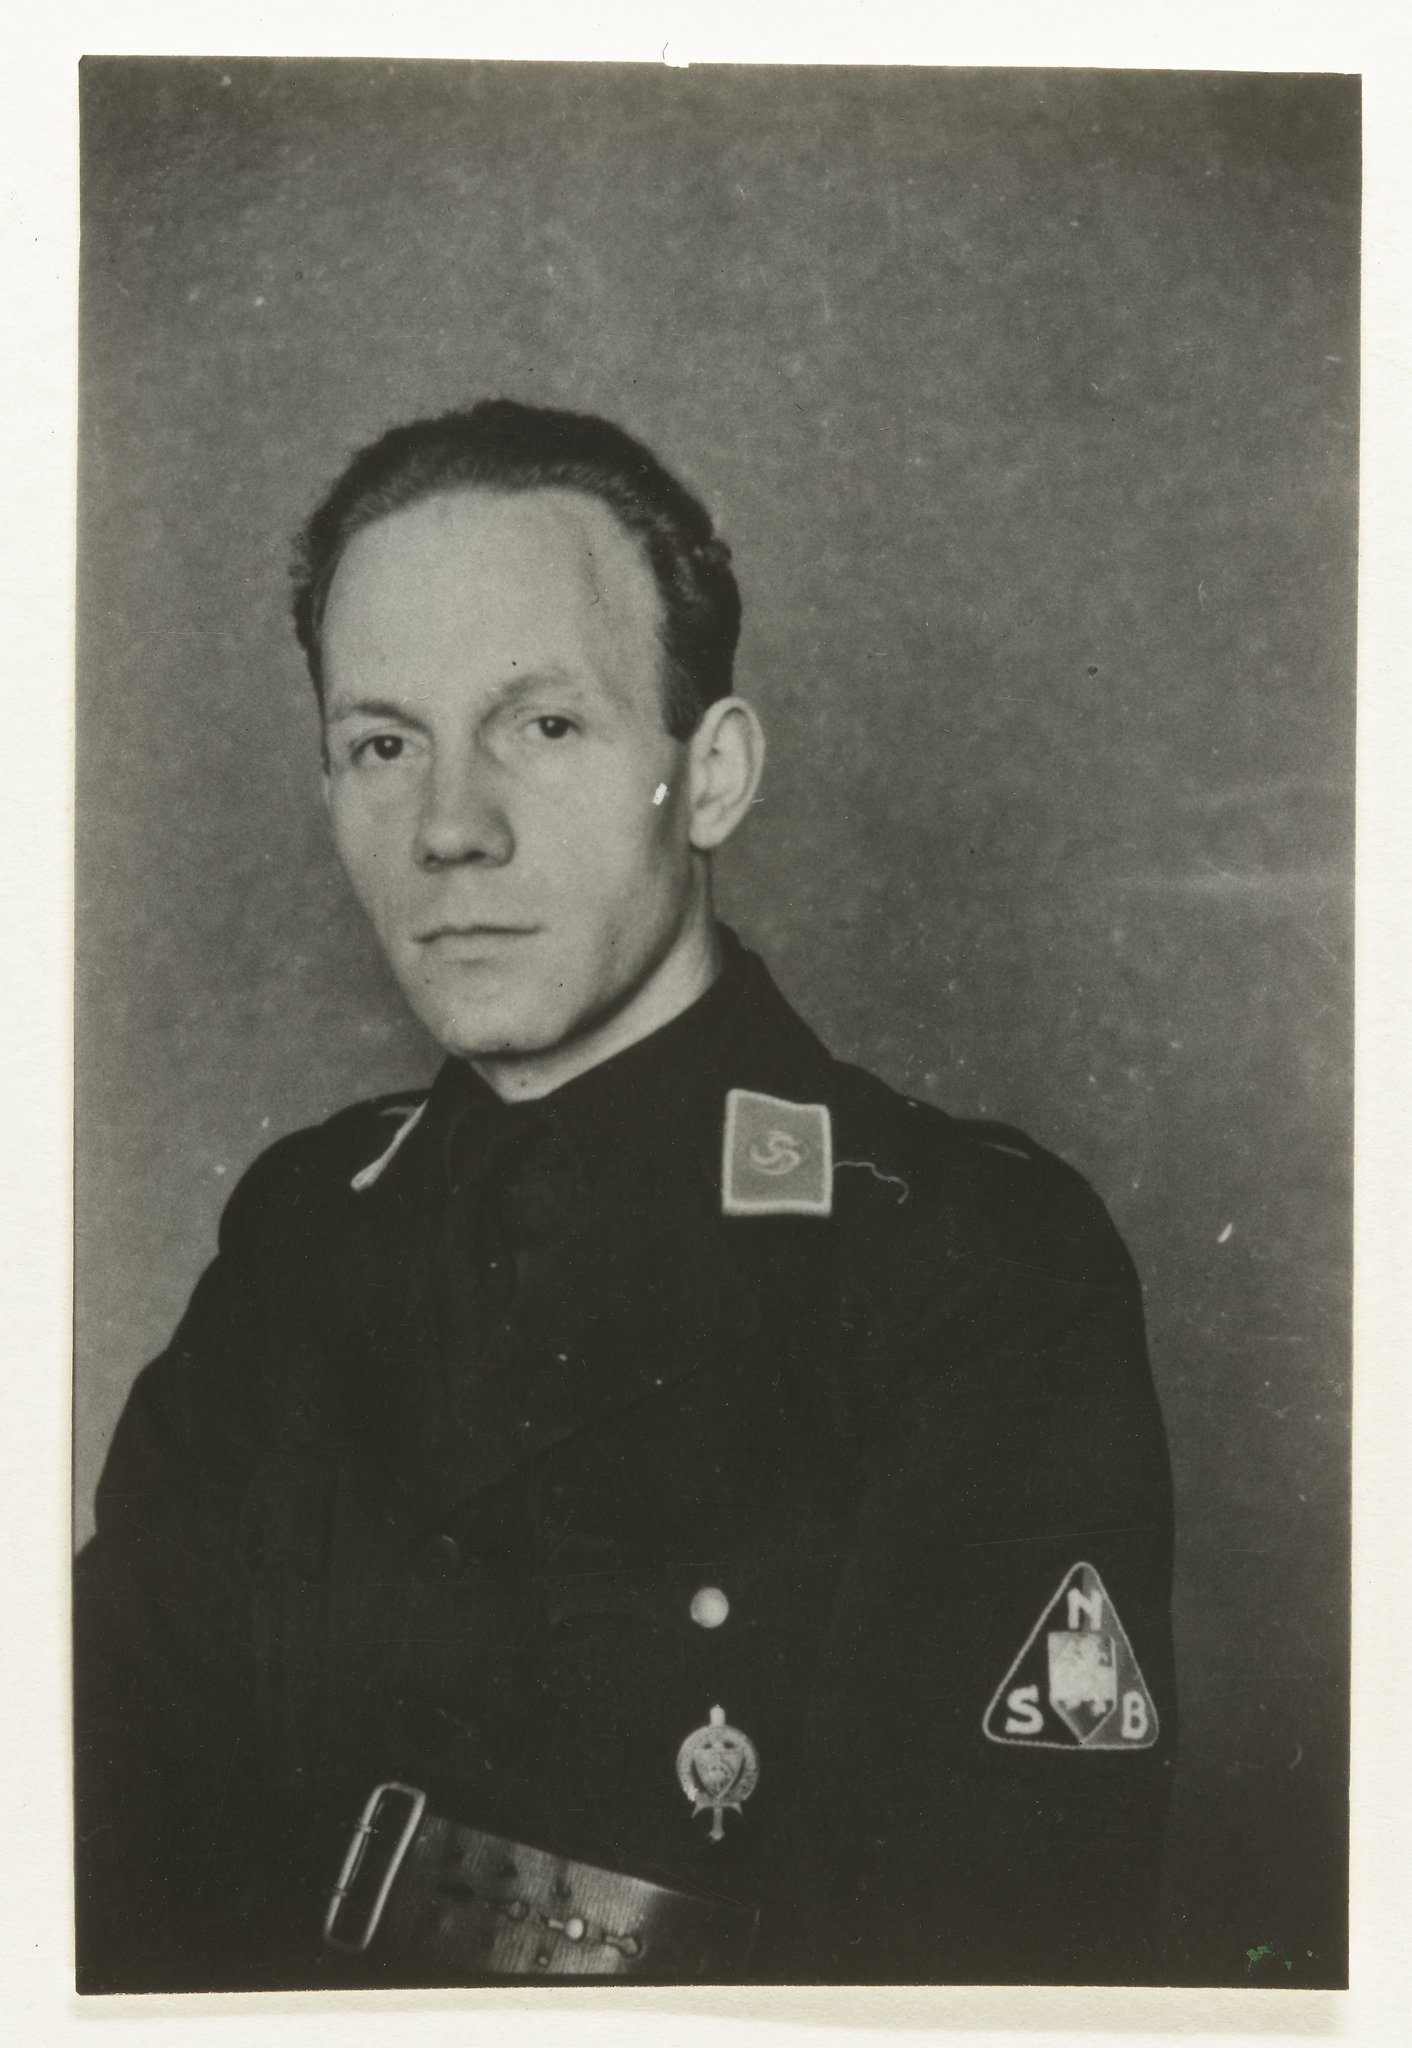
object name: contact print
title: NSB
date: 1940-1944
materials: photographic support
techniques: photography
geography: netherlands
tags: anonymous historical person portrayed, netherlands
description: Portret van een lid van de NSB. Op zijn kraag een distinctief met een wentelend zonnerad, plaatsvervangend sectieleider Fronten en Gilden. Op zijn linkermouw het driehoekige NSB symbool. Op zijn jas is een draagpenning zichtbaar. Hij draagt een riem en is blootshoofd.